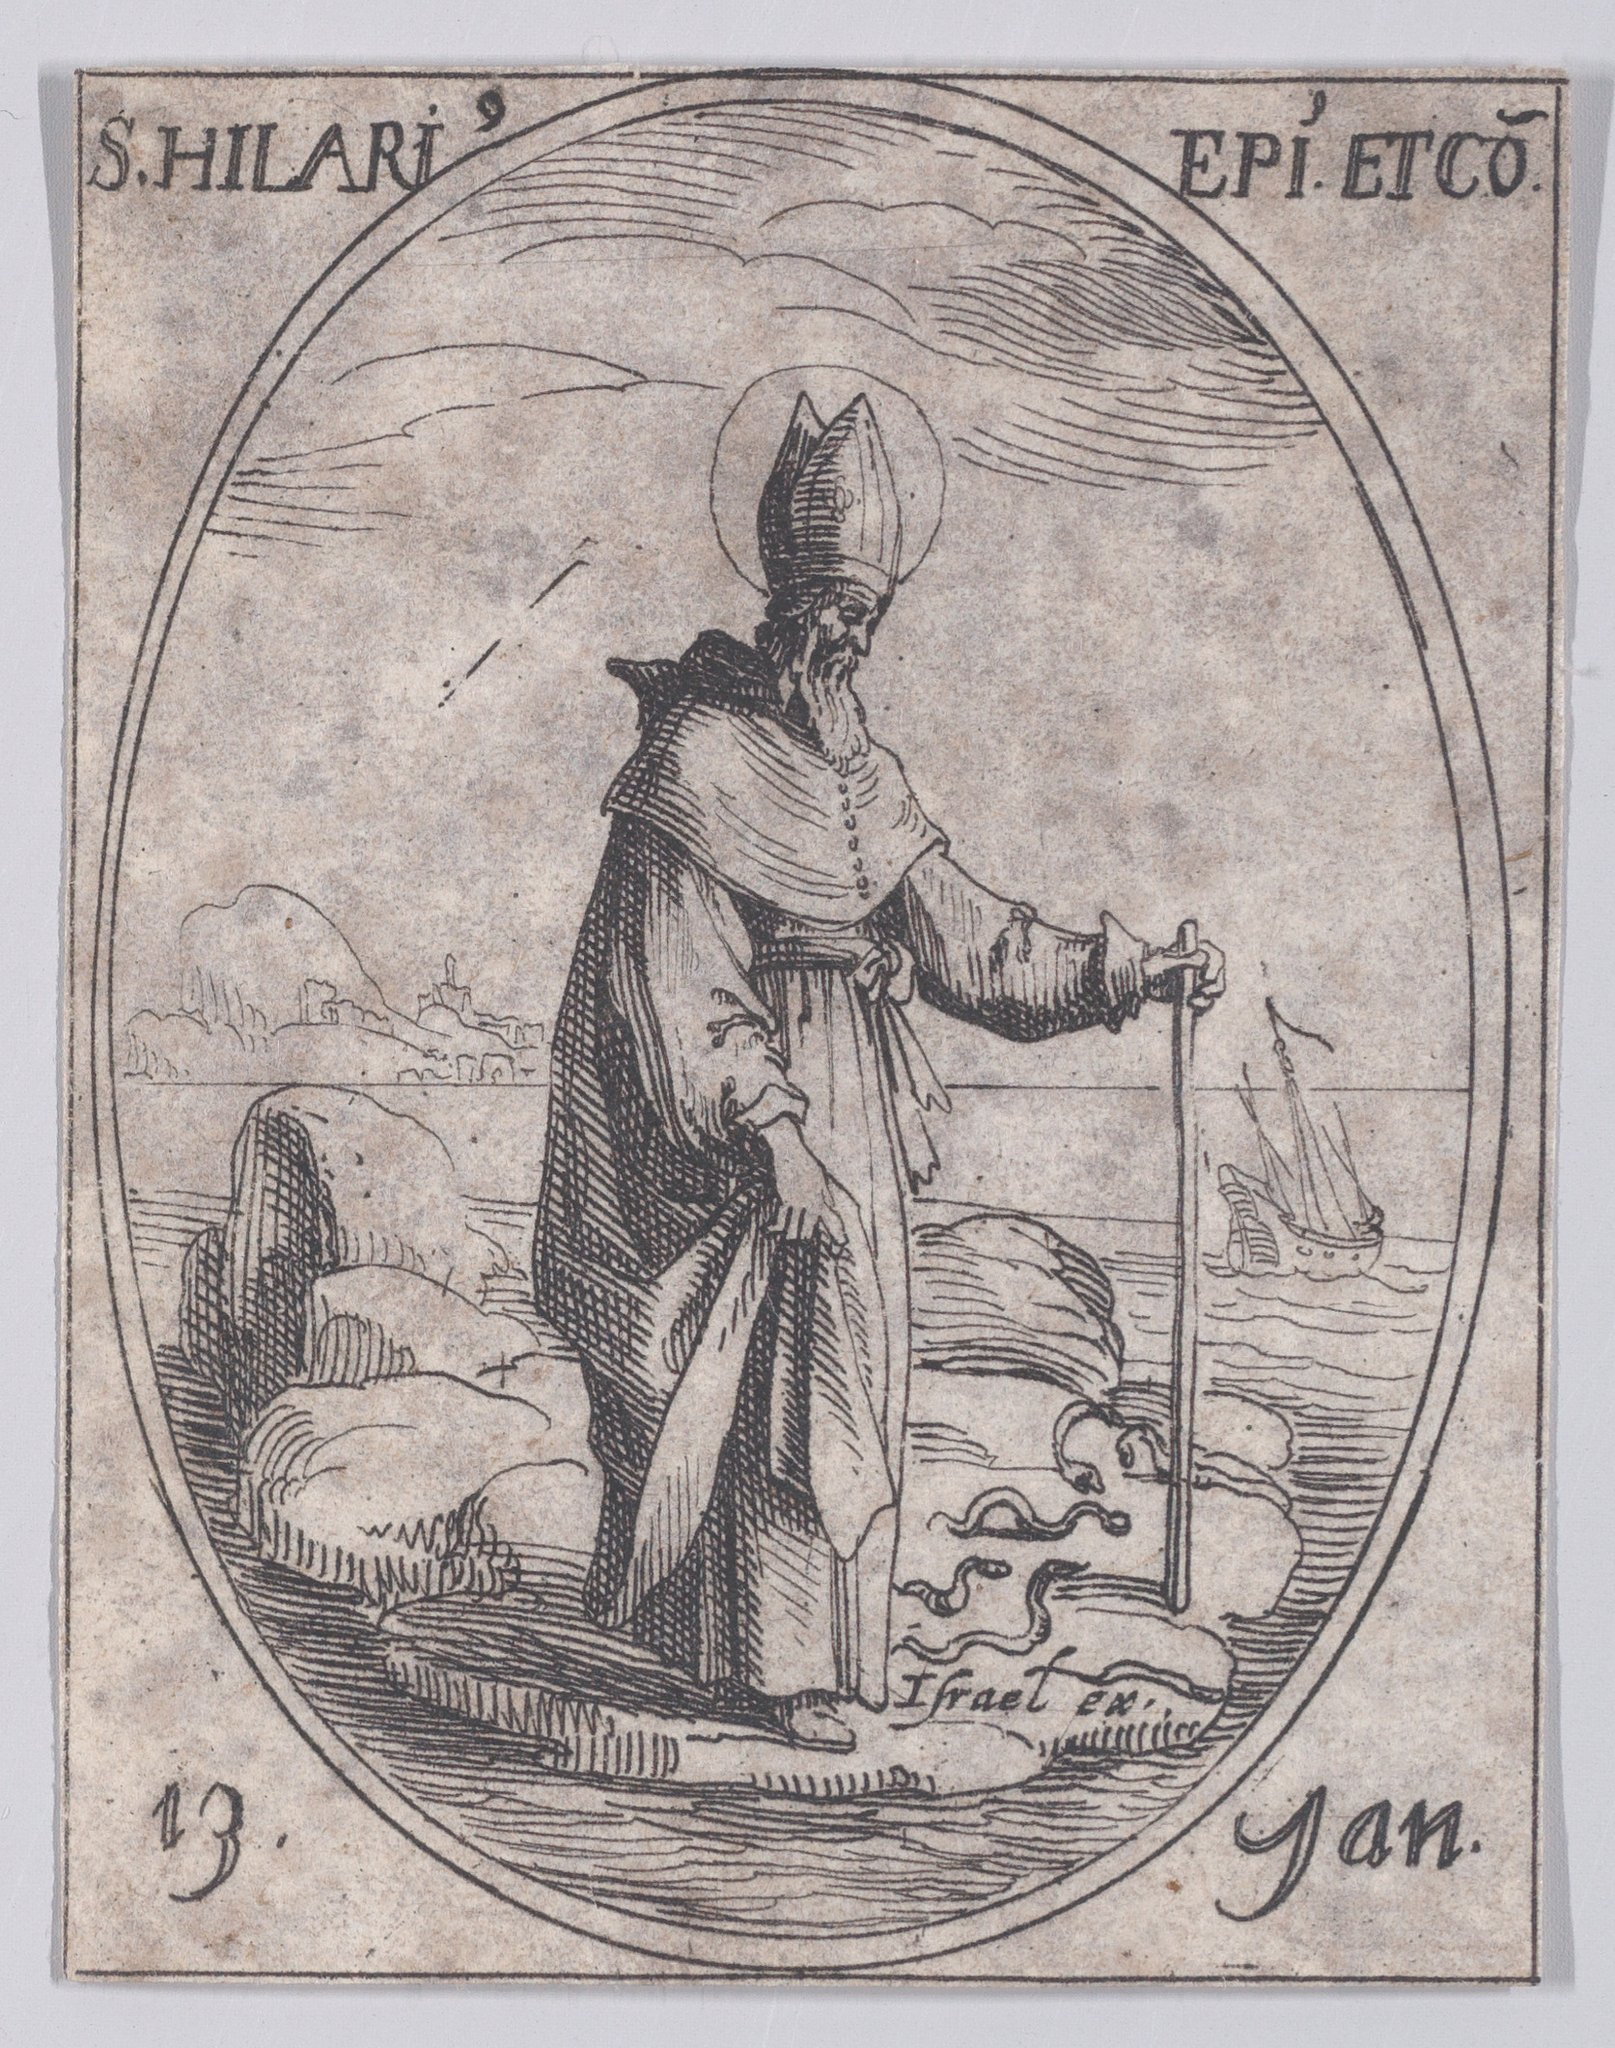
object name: print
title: S. Hilaire, évêque et confesseur (St. Hilary, Bishop and Confessor), January 13th, from "Les Images De Tous Les Saincts et Saintes de L'Année" (Images of All of the Saints and Feast Days of the Year)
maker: jacques callot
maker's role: artist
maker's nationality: french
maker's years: 1592-1635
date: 1636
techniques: etching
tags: men,saints